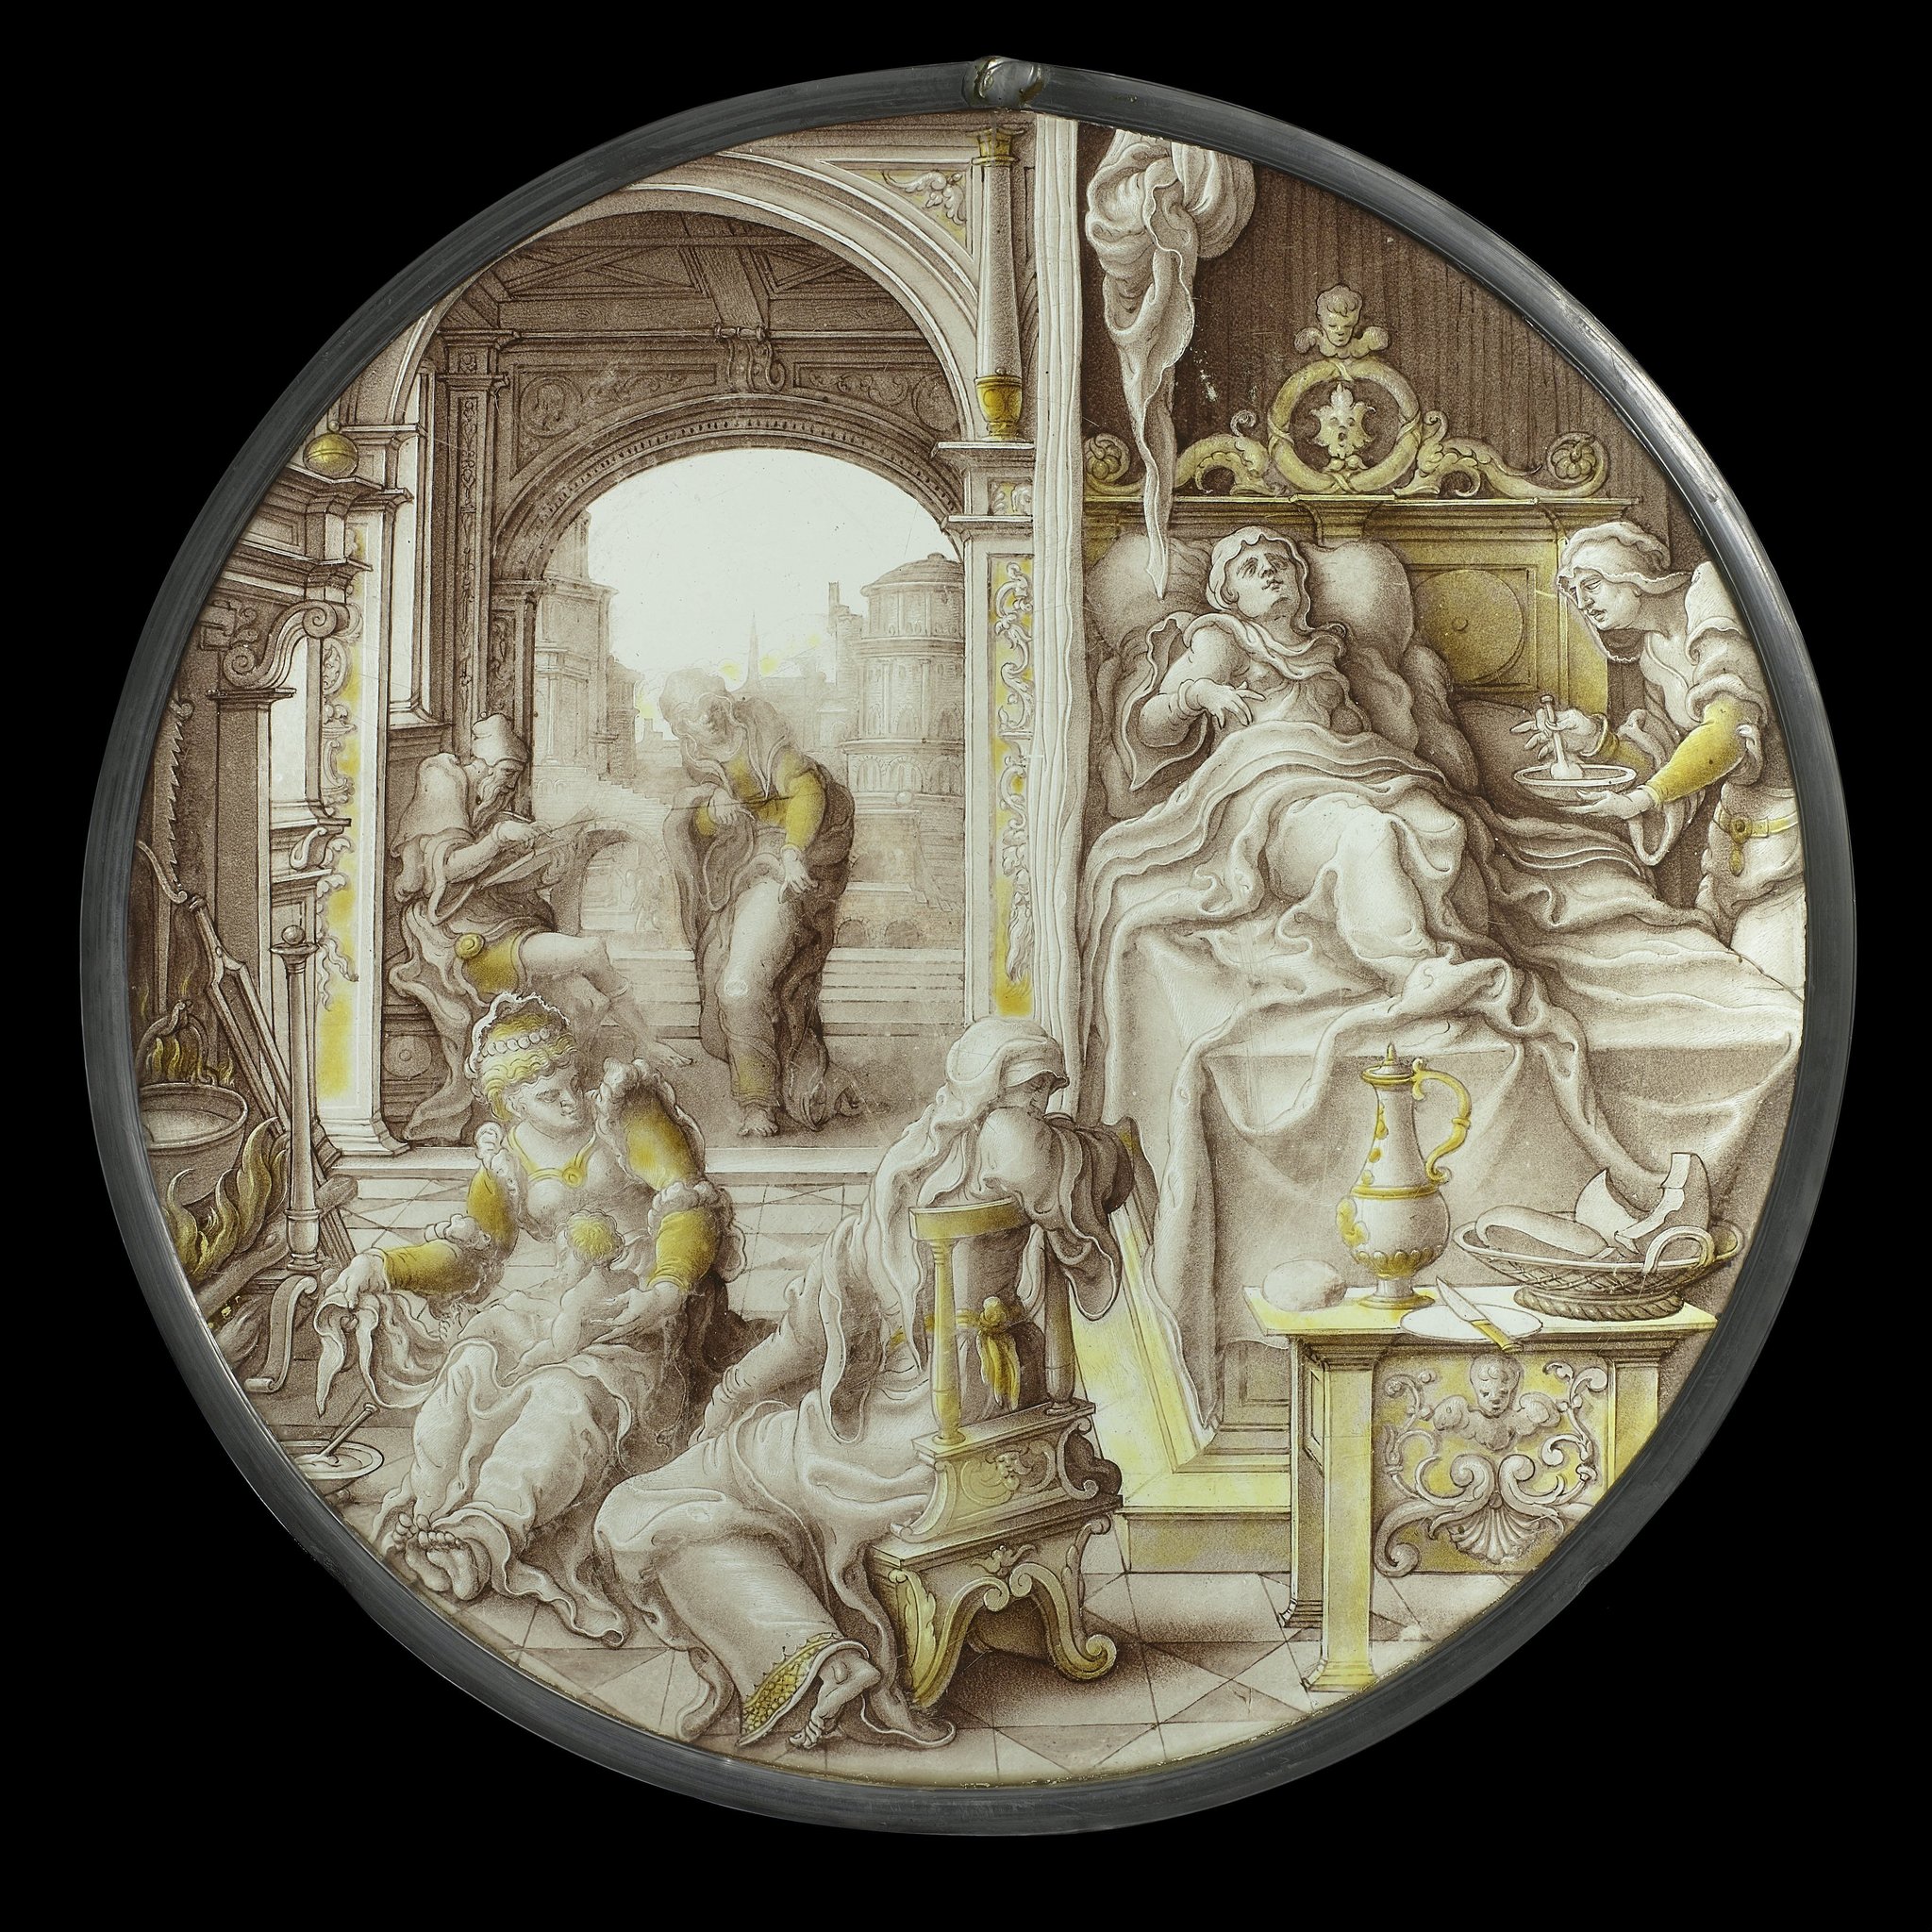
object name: light window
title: The Birth of John the Baptist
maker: Anonymous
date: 1540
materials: glass, lead, pigment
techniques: leading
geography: southern netherlands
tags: birth of john the baptist, sometimes mary present, naming of john the baptist; zacharias writing john's name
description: Ronde gebrandschilderde ruit met een voorstelling van de Geboorte van Johannes de Doper. Elisabeth zit met opgetrokken knieën in het kraambed, in de rug gesteund door kussens. De meubels waarmee het vertrek is ingericht zijn uitgevoerd in gefantaseerde renaissancevormen en -ornament. Aan het voeteneinde staat een tafel met een kan, een mand brood en een mes. Een dienstmaagd geeft haar pap uit een kom. Maria zit op de grond bij het vuur met Johannes op schoot. Een bezoekster kijkt toe, zittend in gedraaide houding op een stoel. Links in de doorgang zit Zacharias, de van zijn spraakvermogen beroofde vader van Johannes, aan een lessenaar.